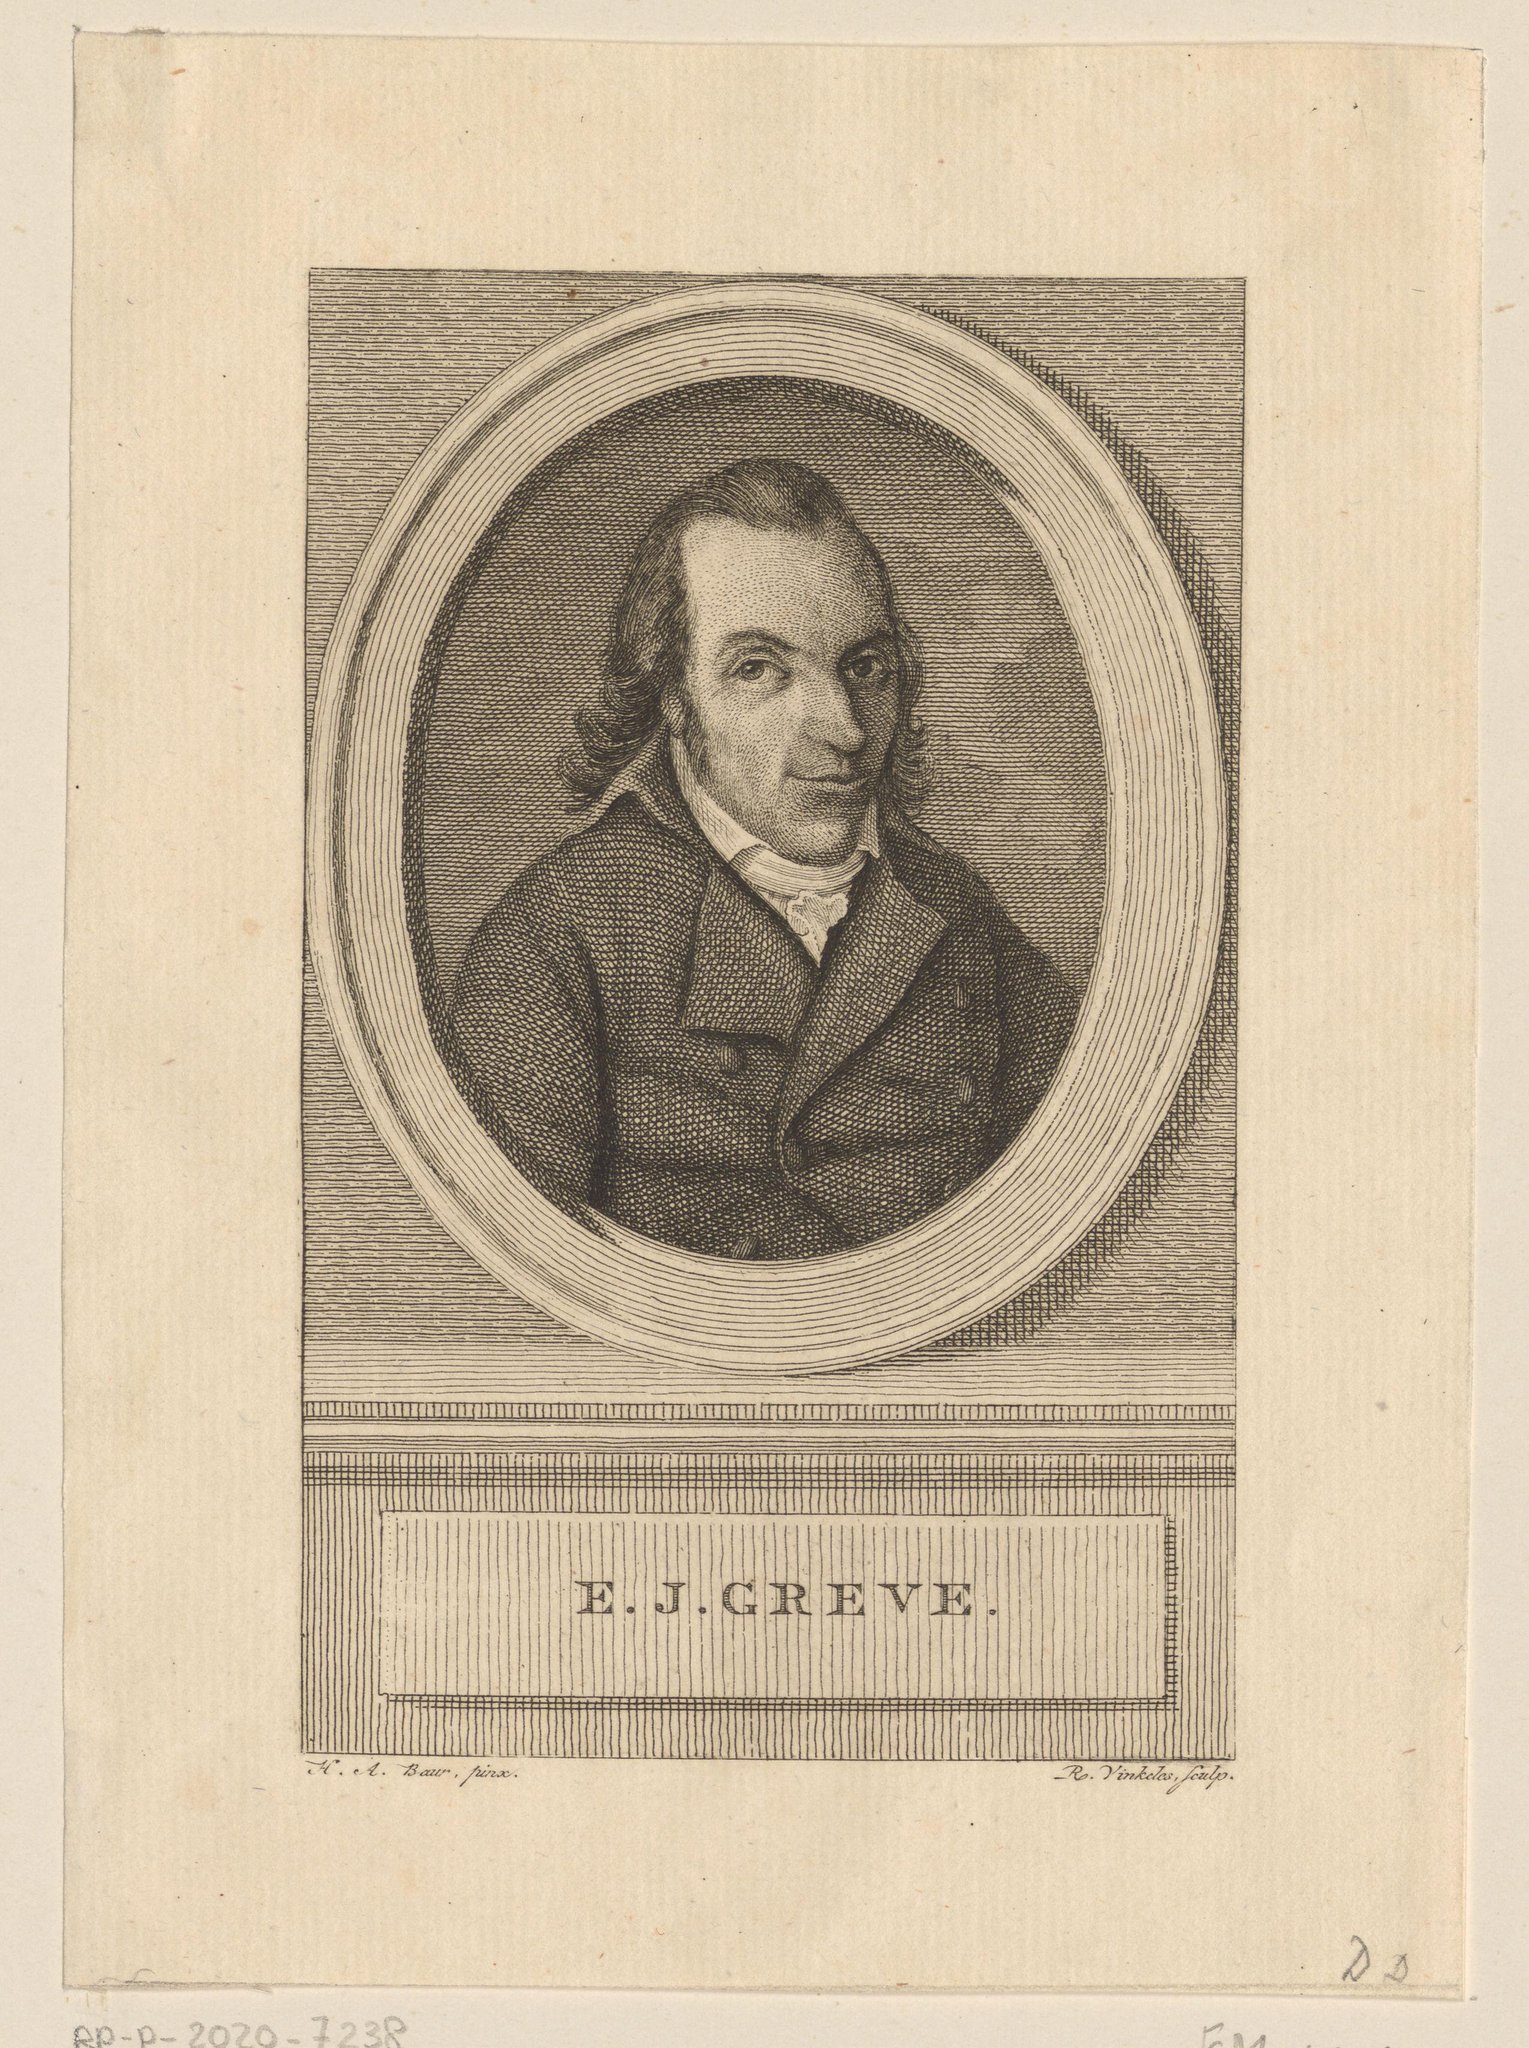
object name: print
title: Portret van Egbert Johan van Greve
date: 1807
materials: paper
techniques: engraving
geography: amsterdam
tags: historical persons, politician, e.g. party leader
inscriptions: collector's mark: Lugt 2166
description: Prent uit: Loosjes, Petrus Adriaanszoon. Vaderlandsche historie, vervattende de geschiedenissen der Vereenigde Nederlanden, zints den aanvang der Noord-Americaansche onlusten [...]. Ten vervolge van Wagenaars Vaderlandsche historie. Amsterdam: Johannes Allart, 1807, dl. 14, p. 86.